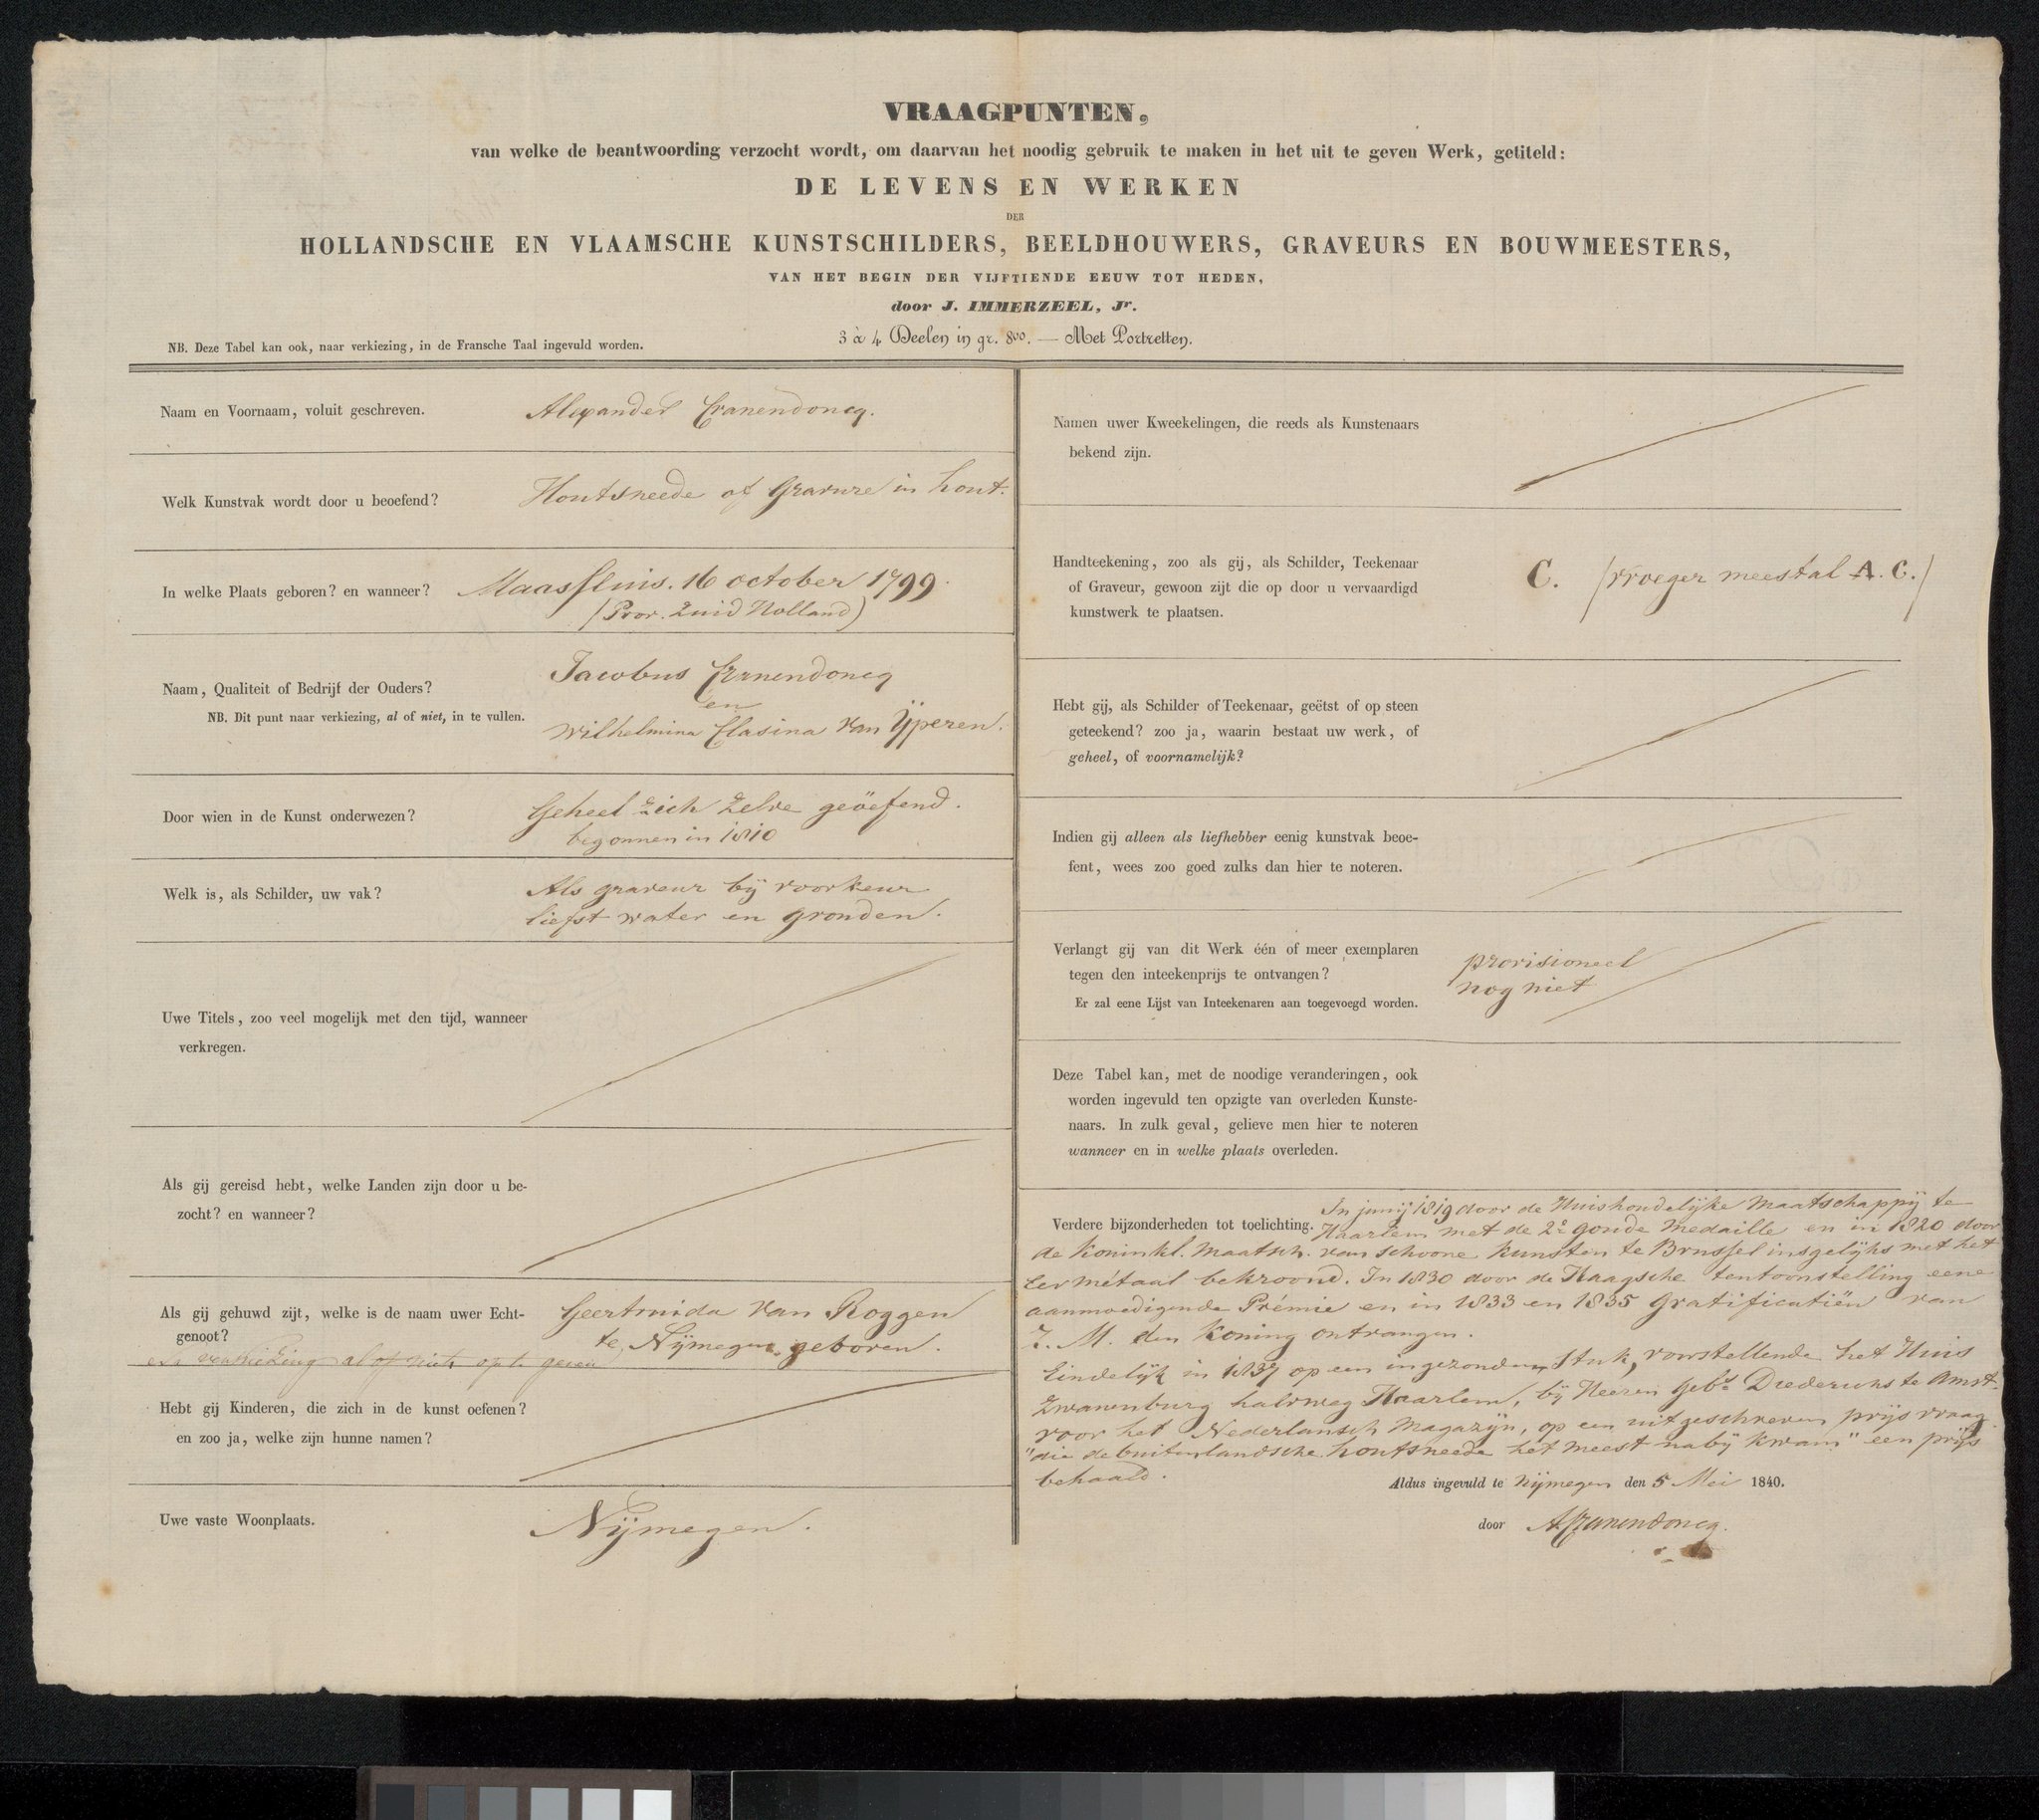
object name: questionnaire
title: Enquêteformulier ingevuld door Alexander Cranendoncq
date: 1840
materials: ink, paper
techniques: pen, printing, writing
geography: nijmegen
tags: nijmegen, print maker, draughtsman, alexander cranendoncq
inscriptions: inscription: ‘Vraagpunten,/ van welke de beantwoording verzocht wordt, om daarvan het noodig gebruik te maken in het uit te geven Werk, getiteld: De levens en werken/ der Hollandsche en Vlaamsche kunstschilders, beeldhouwers,/ graveurs en bouwmeesters, van het begin der vijftiende eeuw tot heden/ door J. Immerzeel, Jr.’, watermark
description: Opgenomen in: Immerzeel, J. Jr., De levens en werken der Hollandsche en Vlaamsche kunstschilders, beeldhouwers, graveurs en bouwmeesters, van het begin der vijftiende eeuw tot heden, Amsterdam: J.C. van Kesteren, 1842-1843.